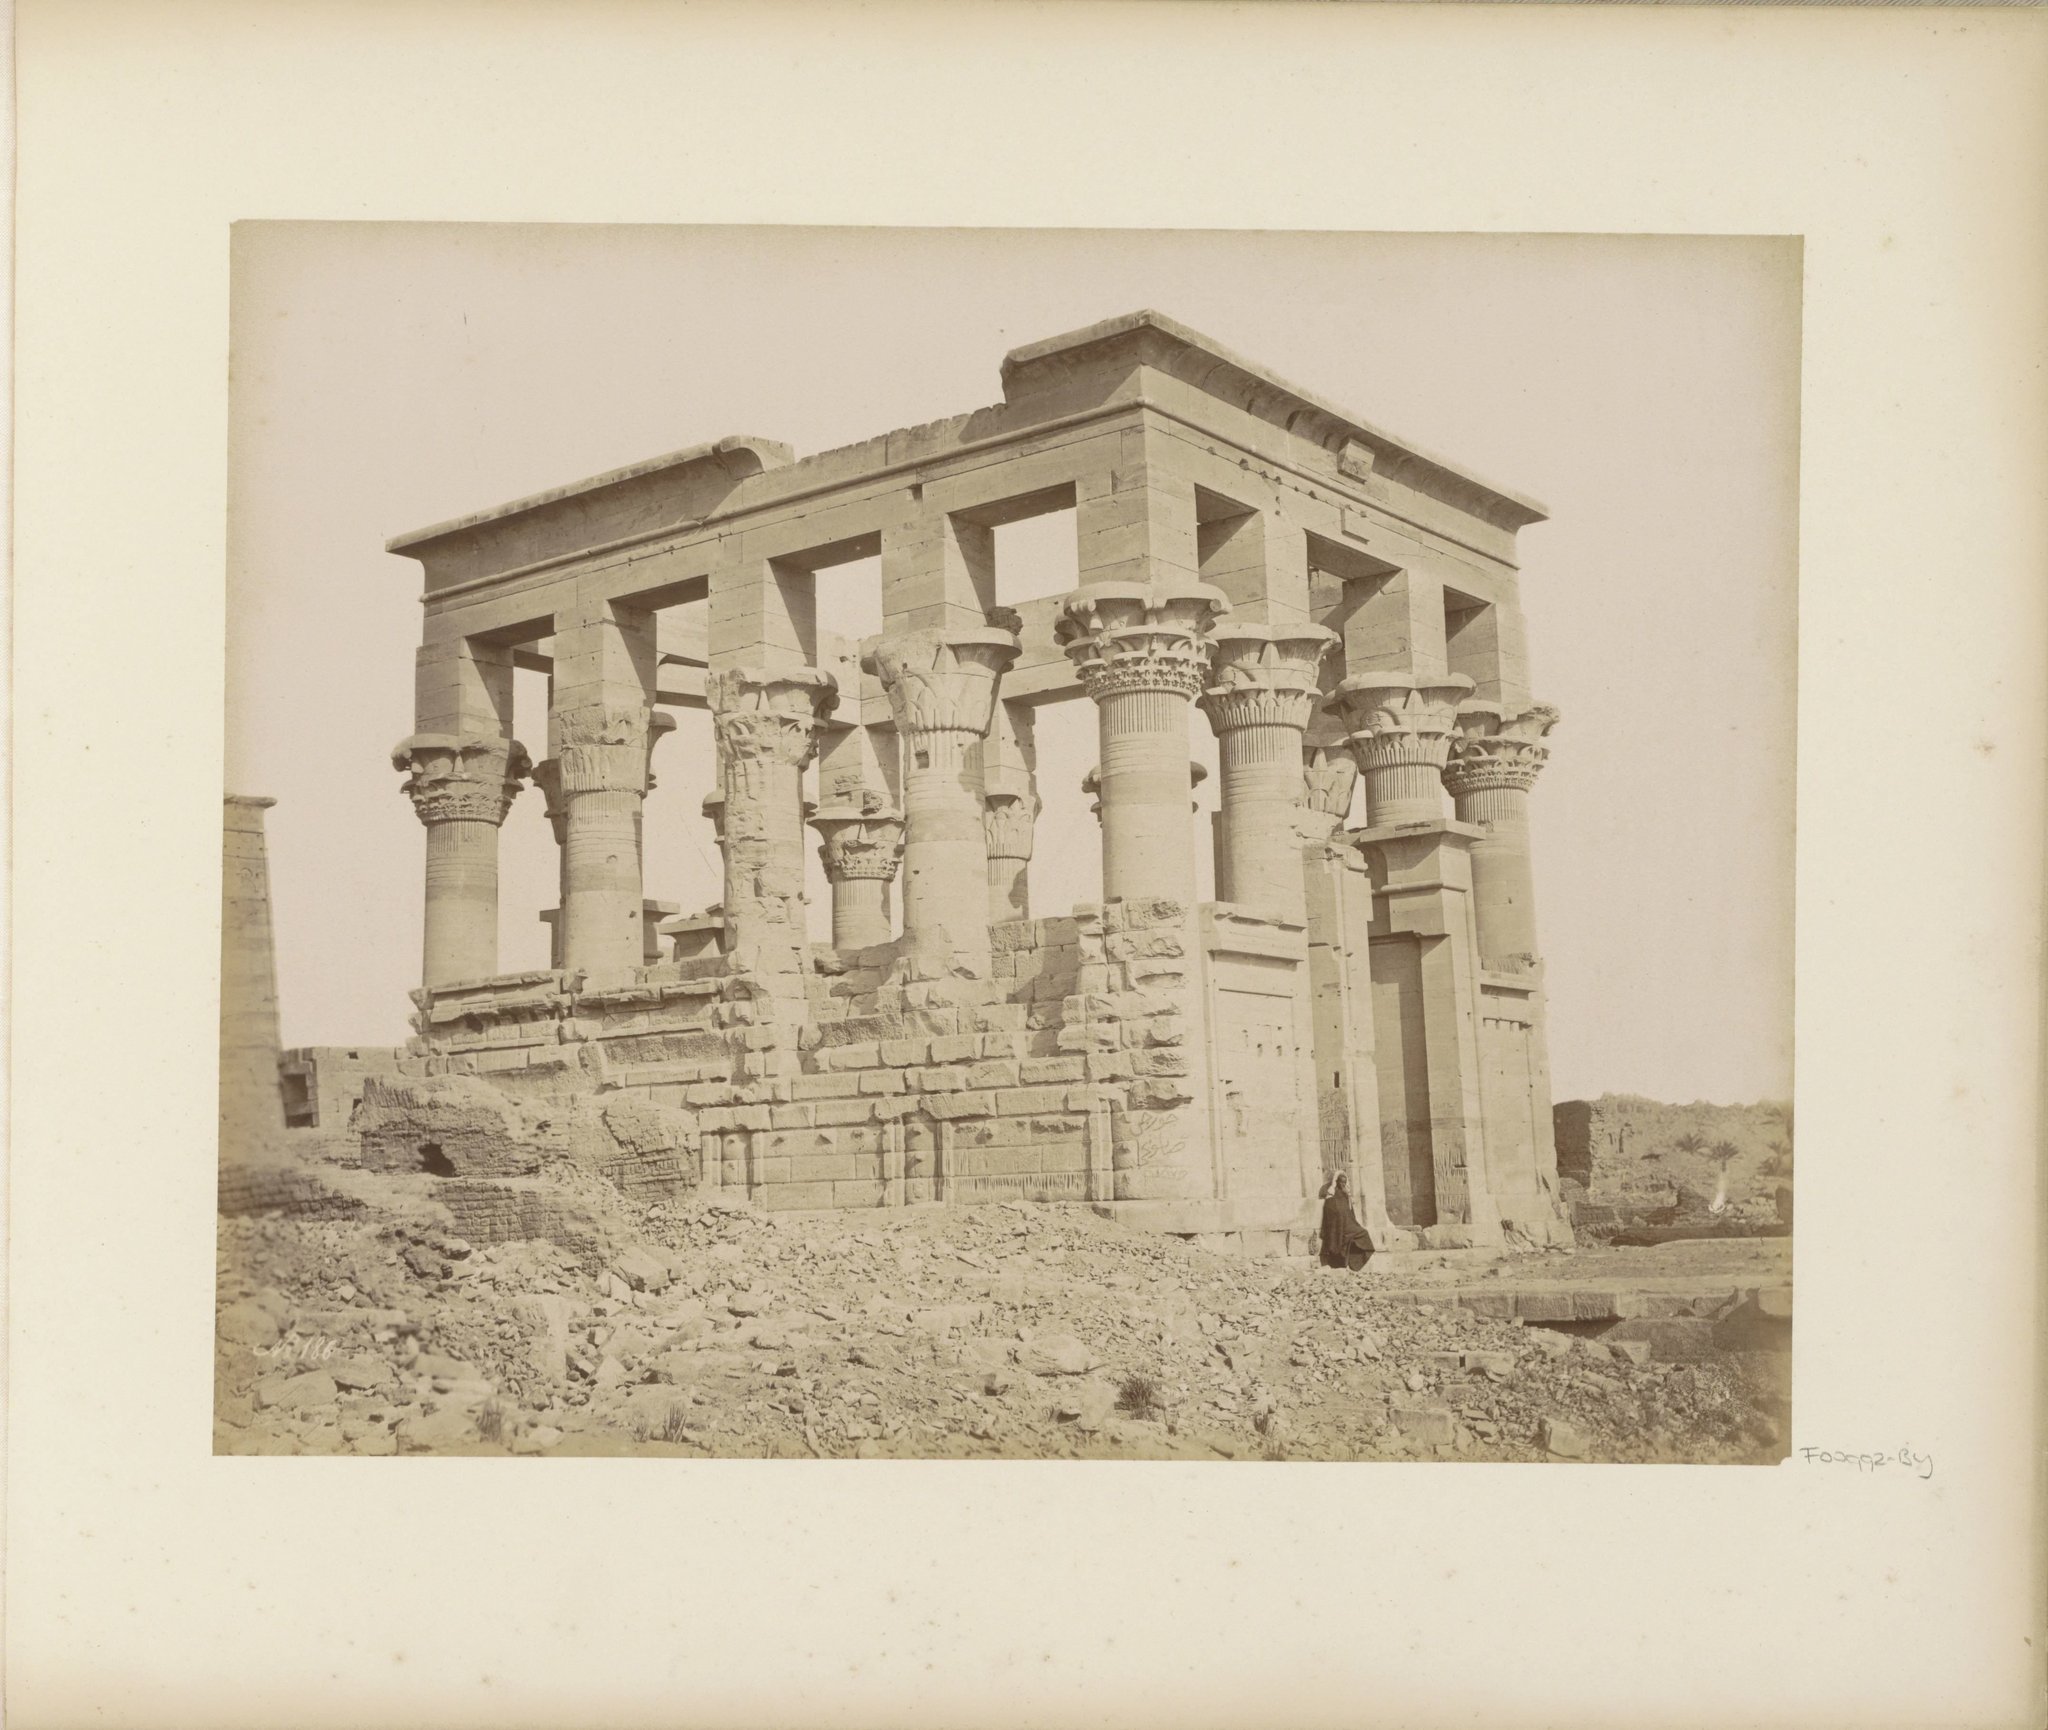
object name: photograph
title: Tempel op het eiland Philae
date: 1870-1890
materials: cardboard, paper, photographic support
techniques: albumen print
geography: philae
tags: temple, shrine ~ egyptian religion, colonnade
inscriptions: negative number: ‘186’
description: Onderdeel van Reisalbum met 80 foto's van Egypte.